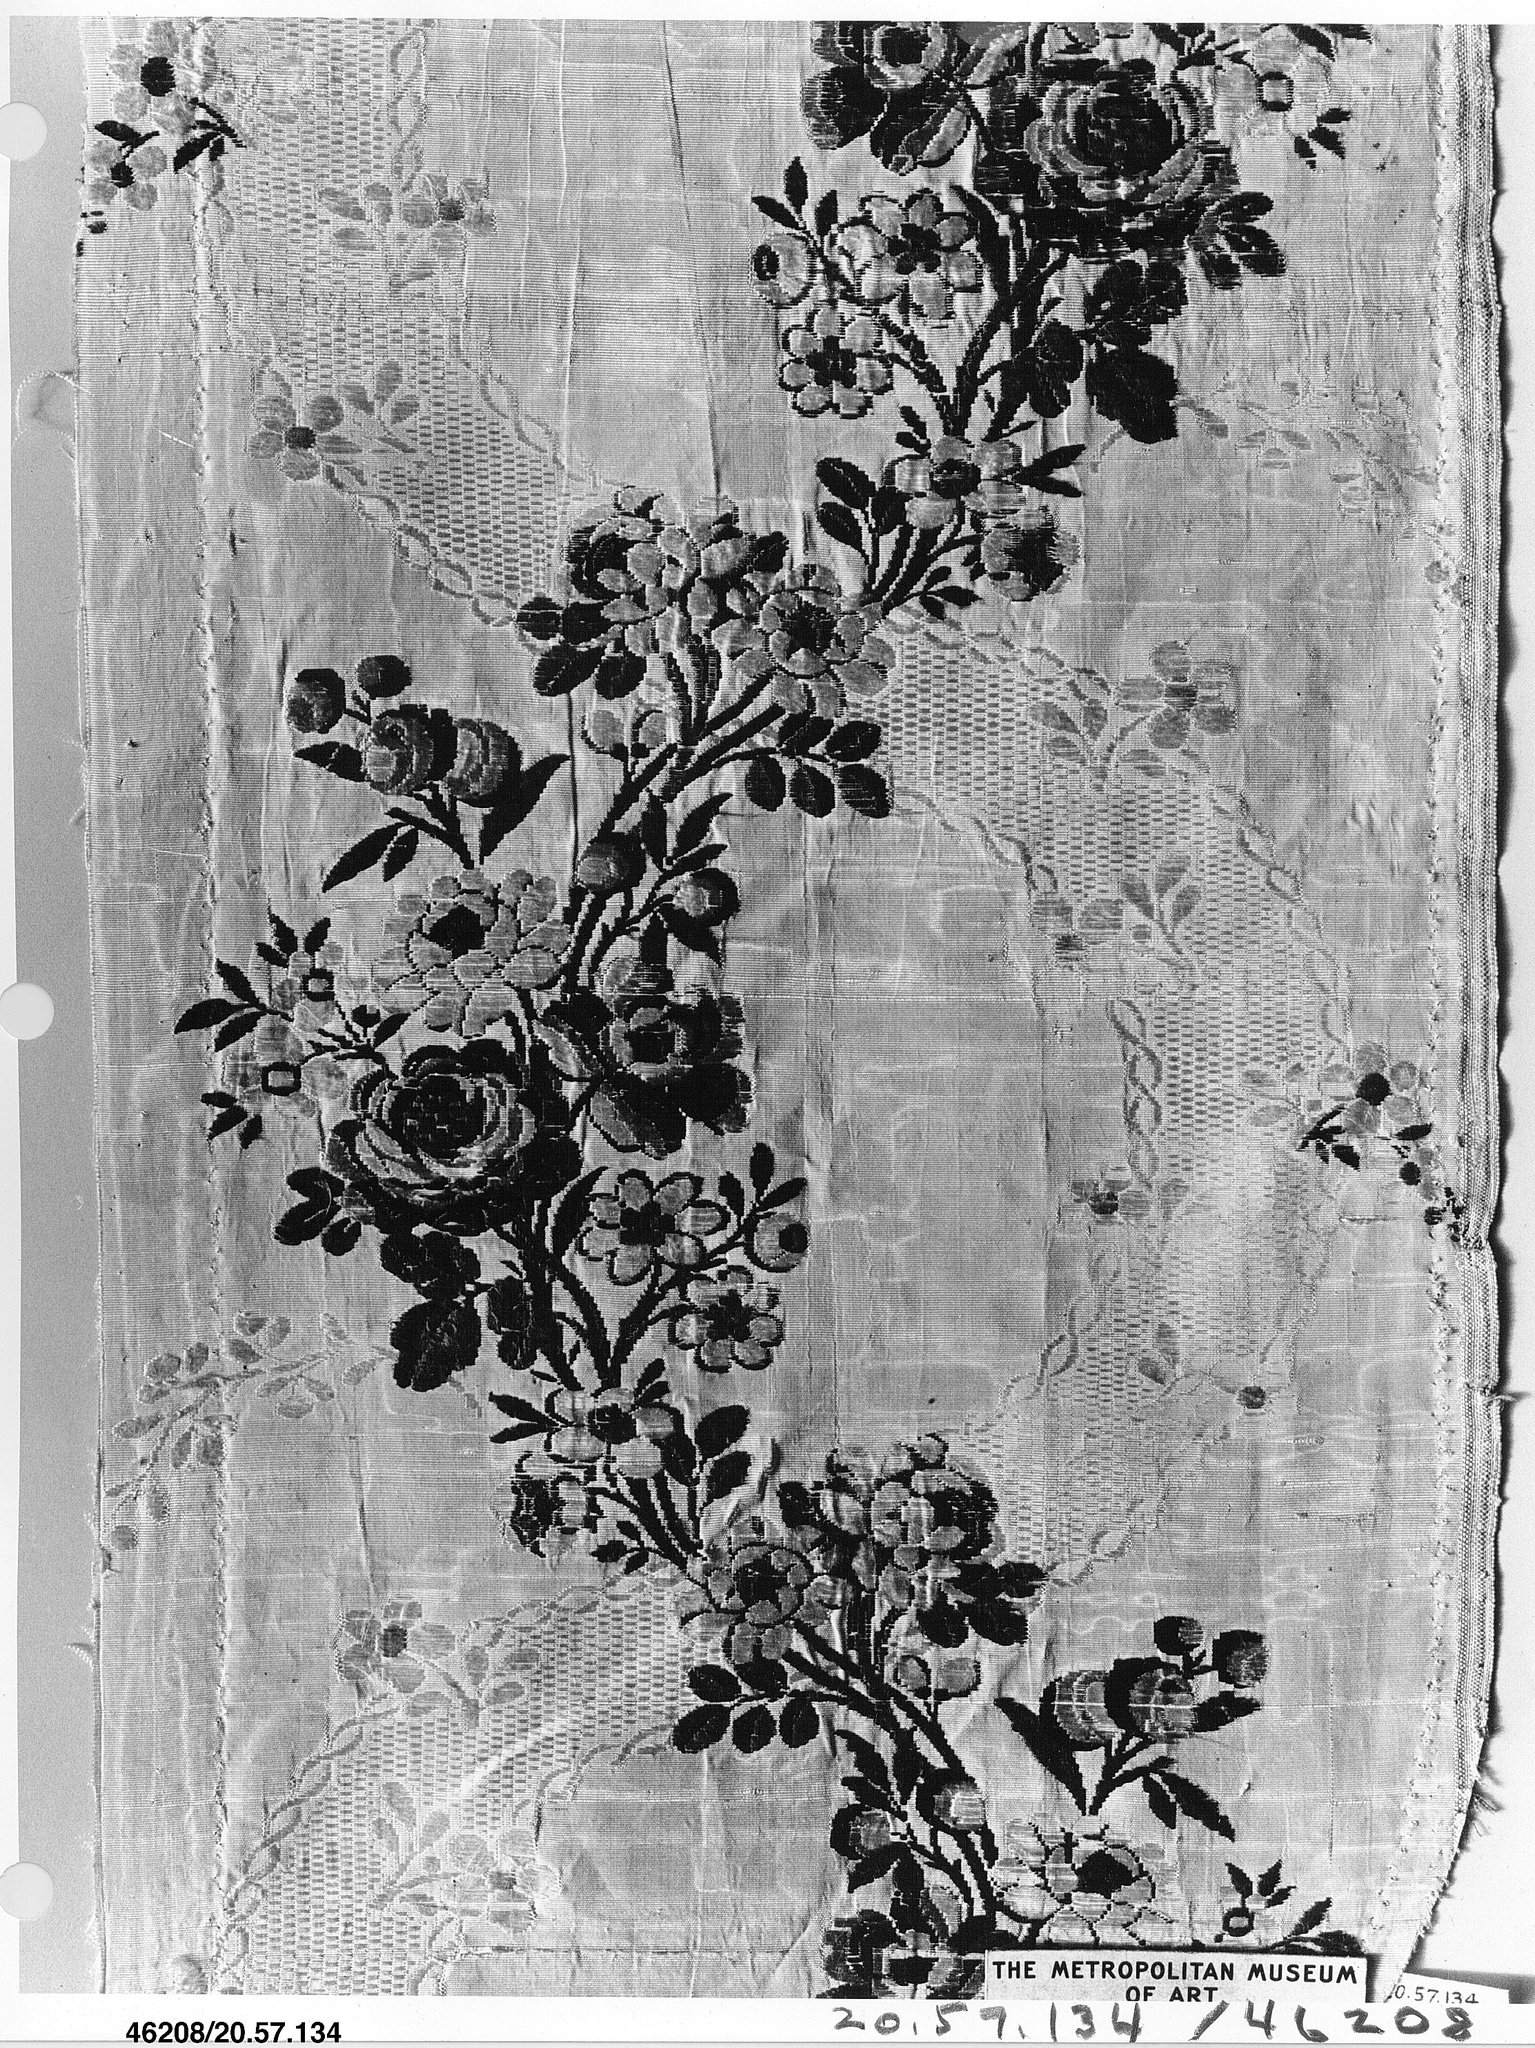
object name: piece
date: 1750-1760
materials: silk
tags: flowers,leaves